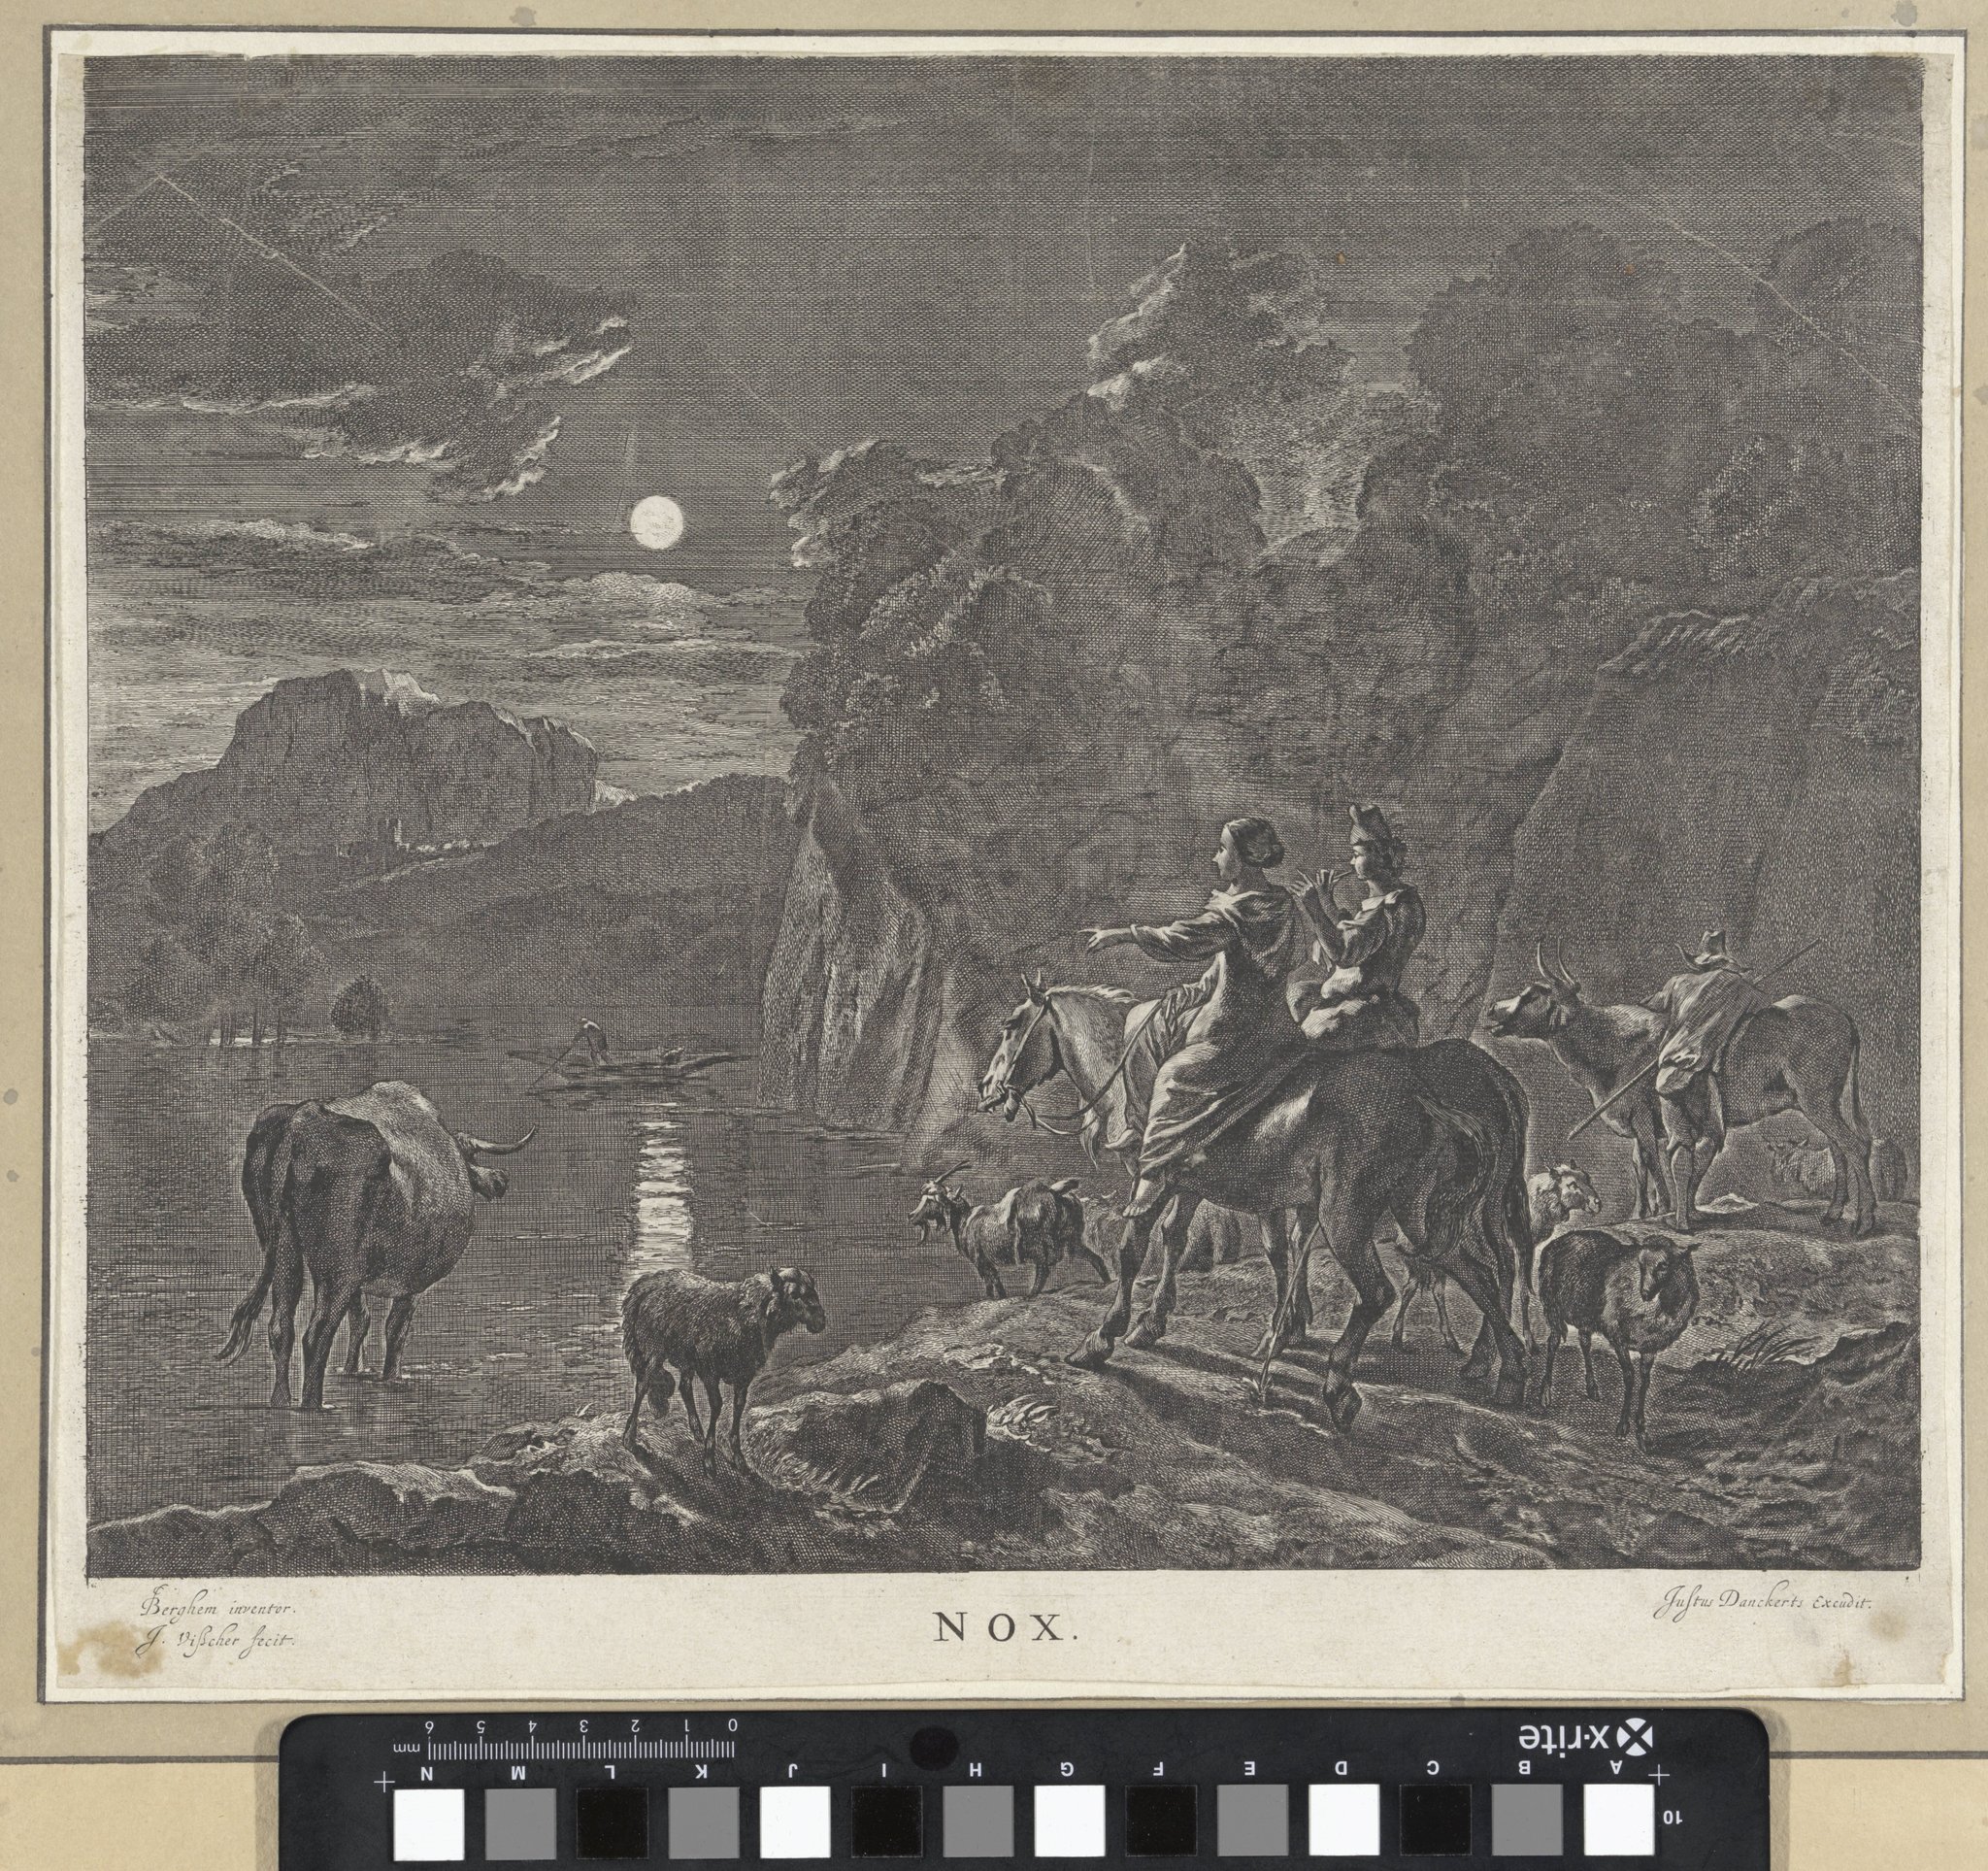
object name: print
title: De vier delen van de dag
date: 1645-1701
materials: paper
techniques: engraving, etching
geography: amsterdam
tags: moonlight, cattle driving, cattle driver, night ~ landscape (sometimes titled 'nox')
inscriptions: title: ‘NOX’, signature: ‘Berghem inventor’, collector's mark: Lugt 240, signature: ‘J. Visscher fecit’, address: ‘Justus Danckerts Excudit’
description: Gezicht op een heuvelachtig landschap bij nacht. De volle maan schijnt. Een herder en herderin te paard laten hun vee drinken uit een meer. Op de achtergrond een man in een bootje en de contouren van een dorp.